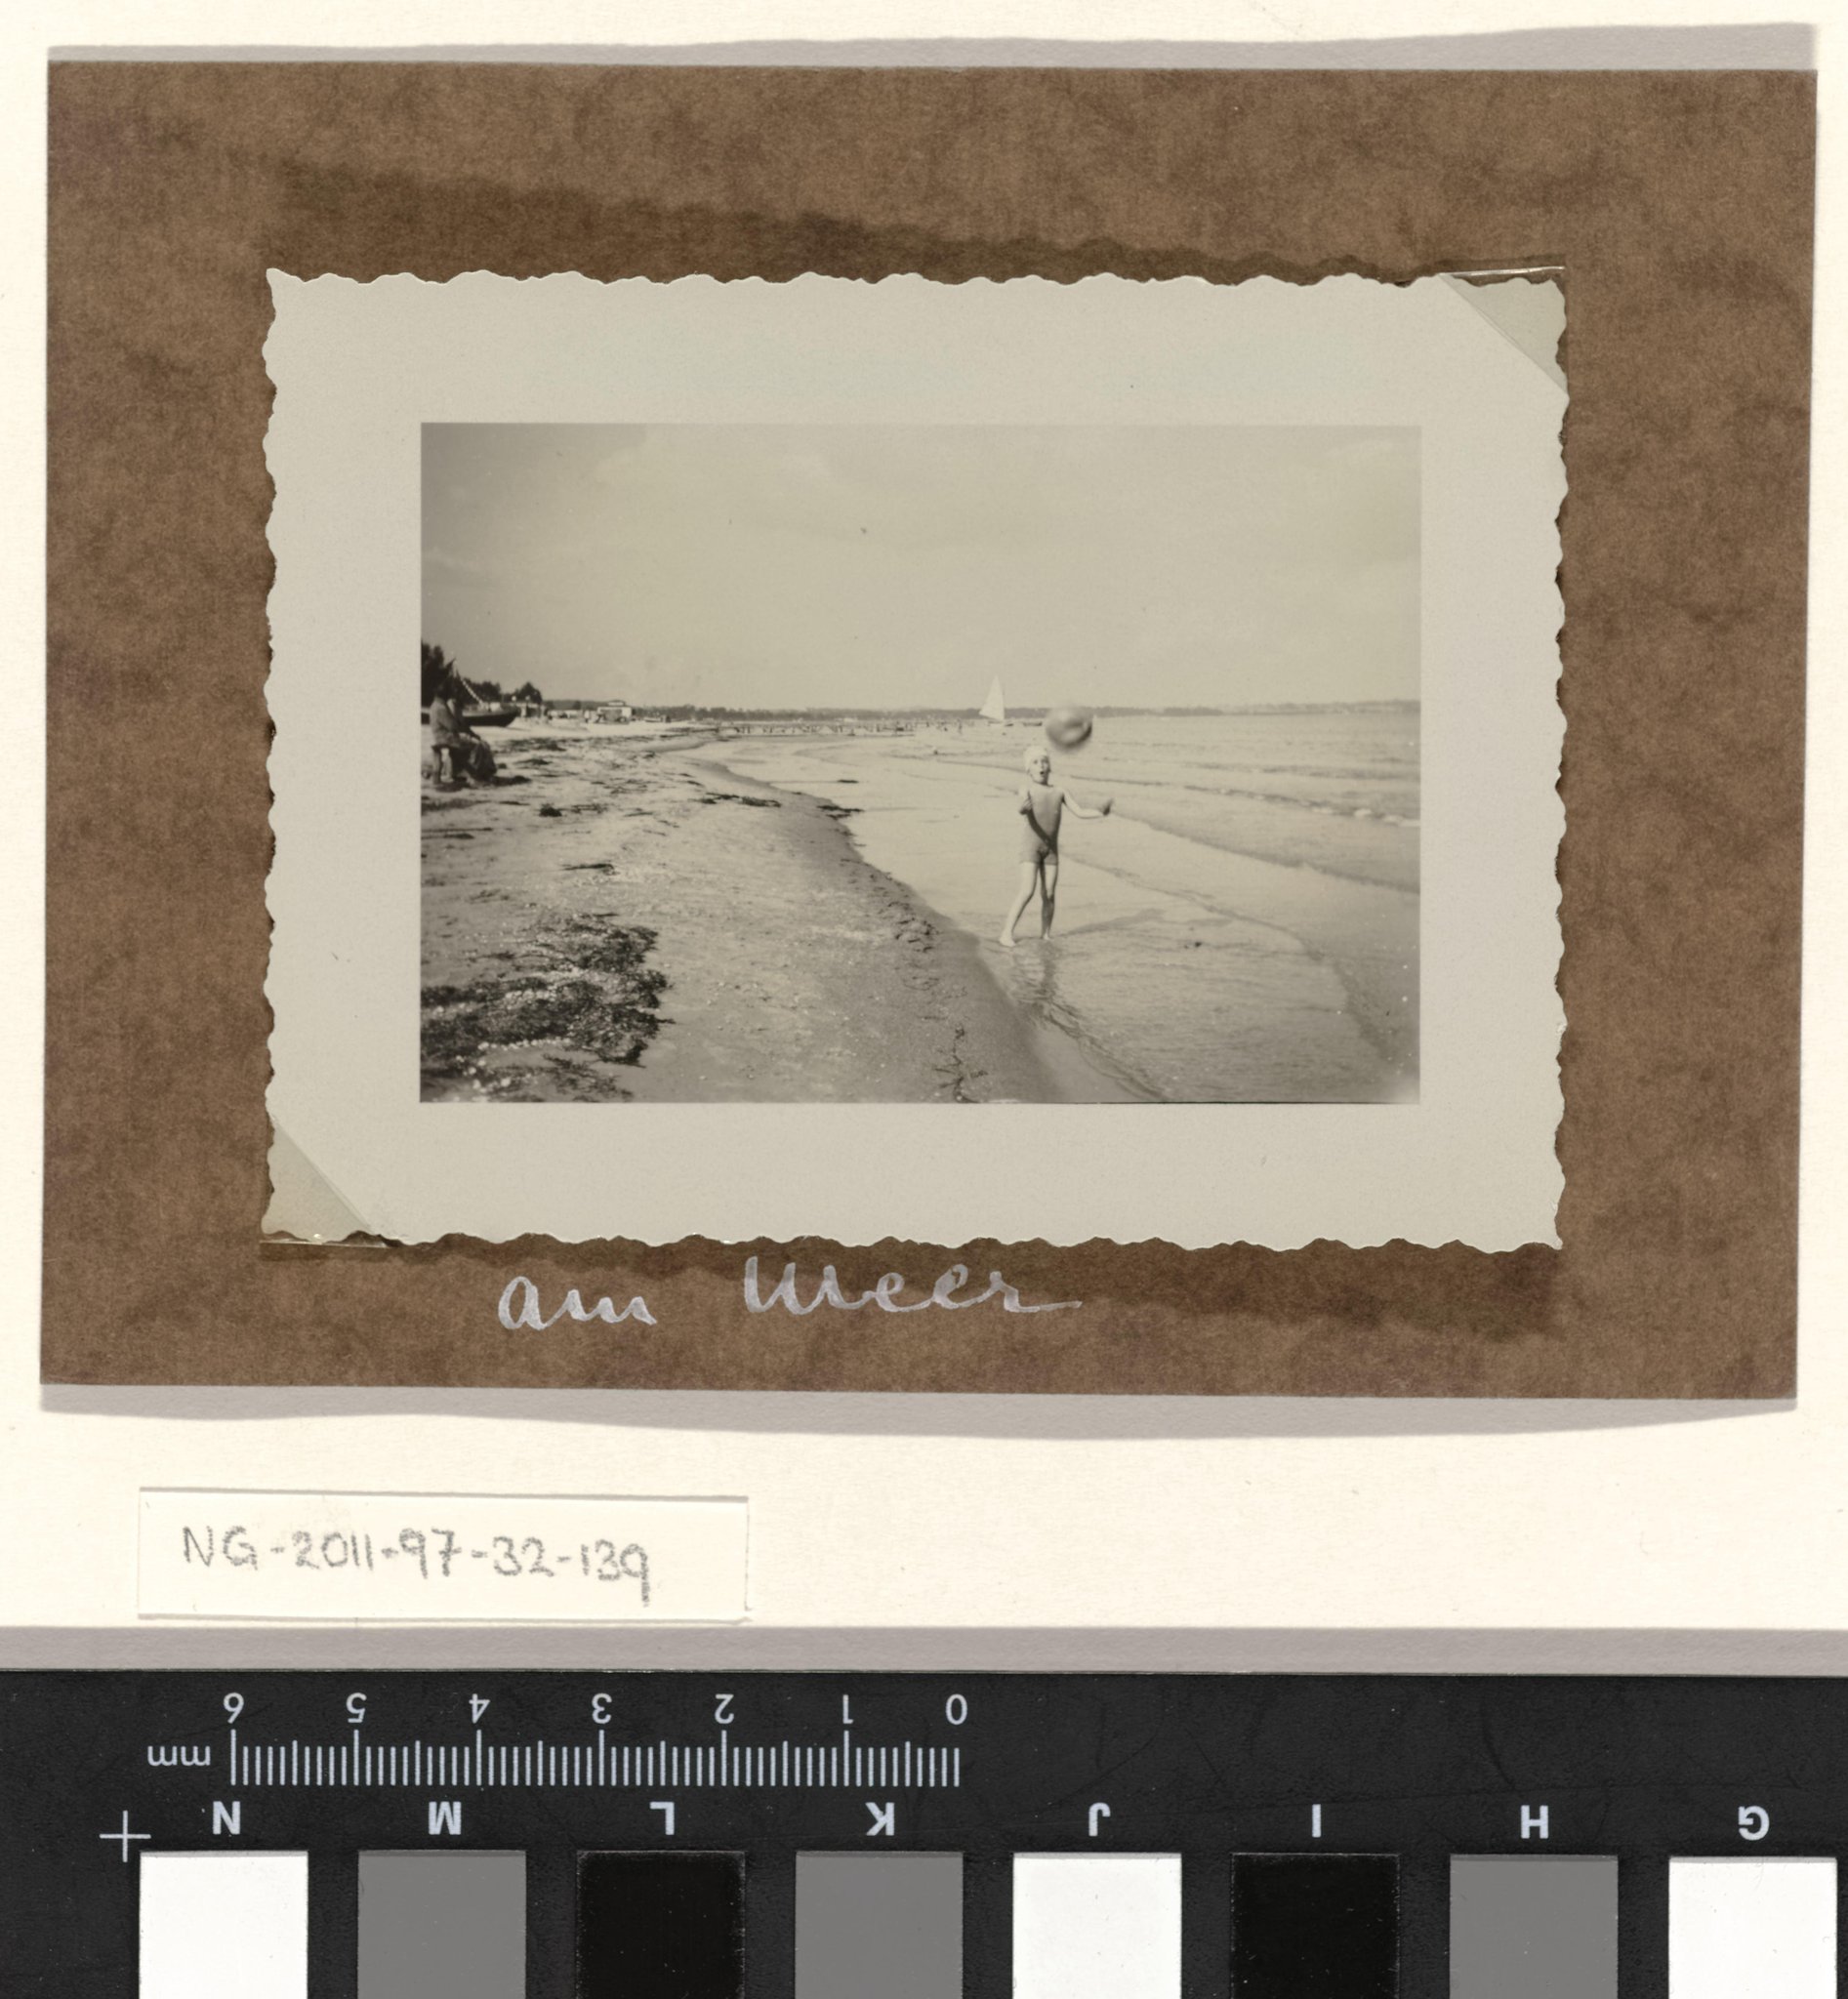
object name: photograph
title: Isabel Wachenheimer op het strand bij de zee, gooiend met een bal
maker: Anonymous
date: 1909-1934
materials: photographic support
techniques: gelatin silver print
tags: leiden, isabel wachenheimer-elon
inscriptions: inscription: ‘am Meer’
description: Isabel Wachenheimer op het strand bij de zee, gooiend met een bal.